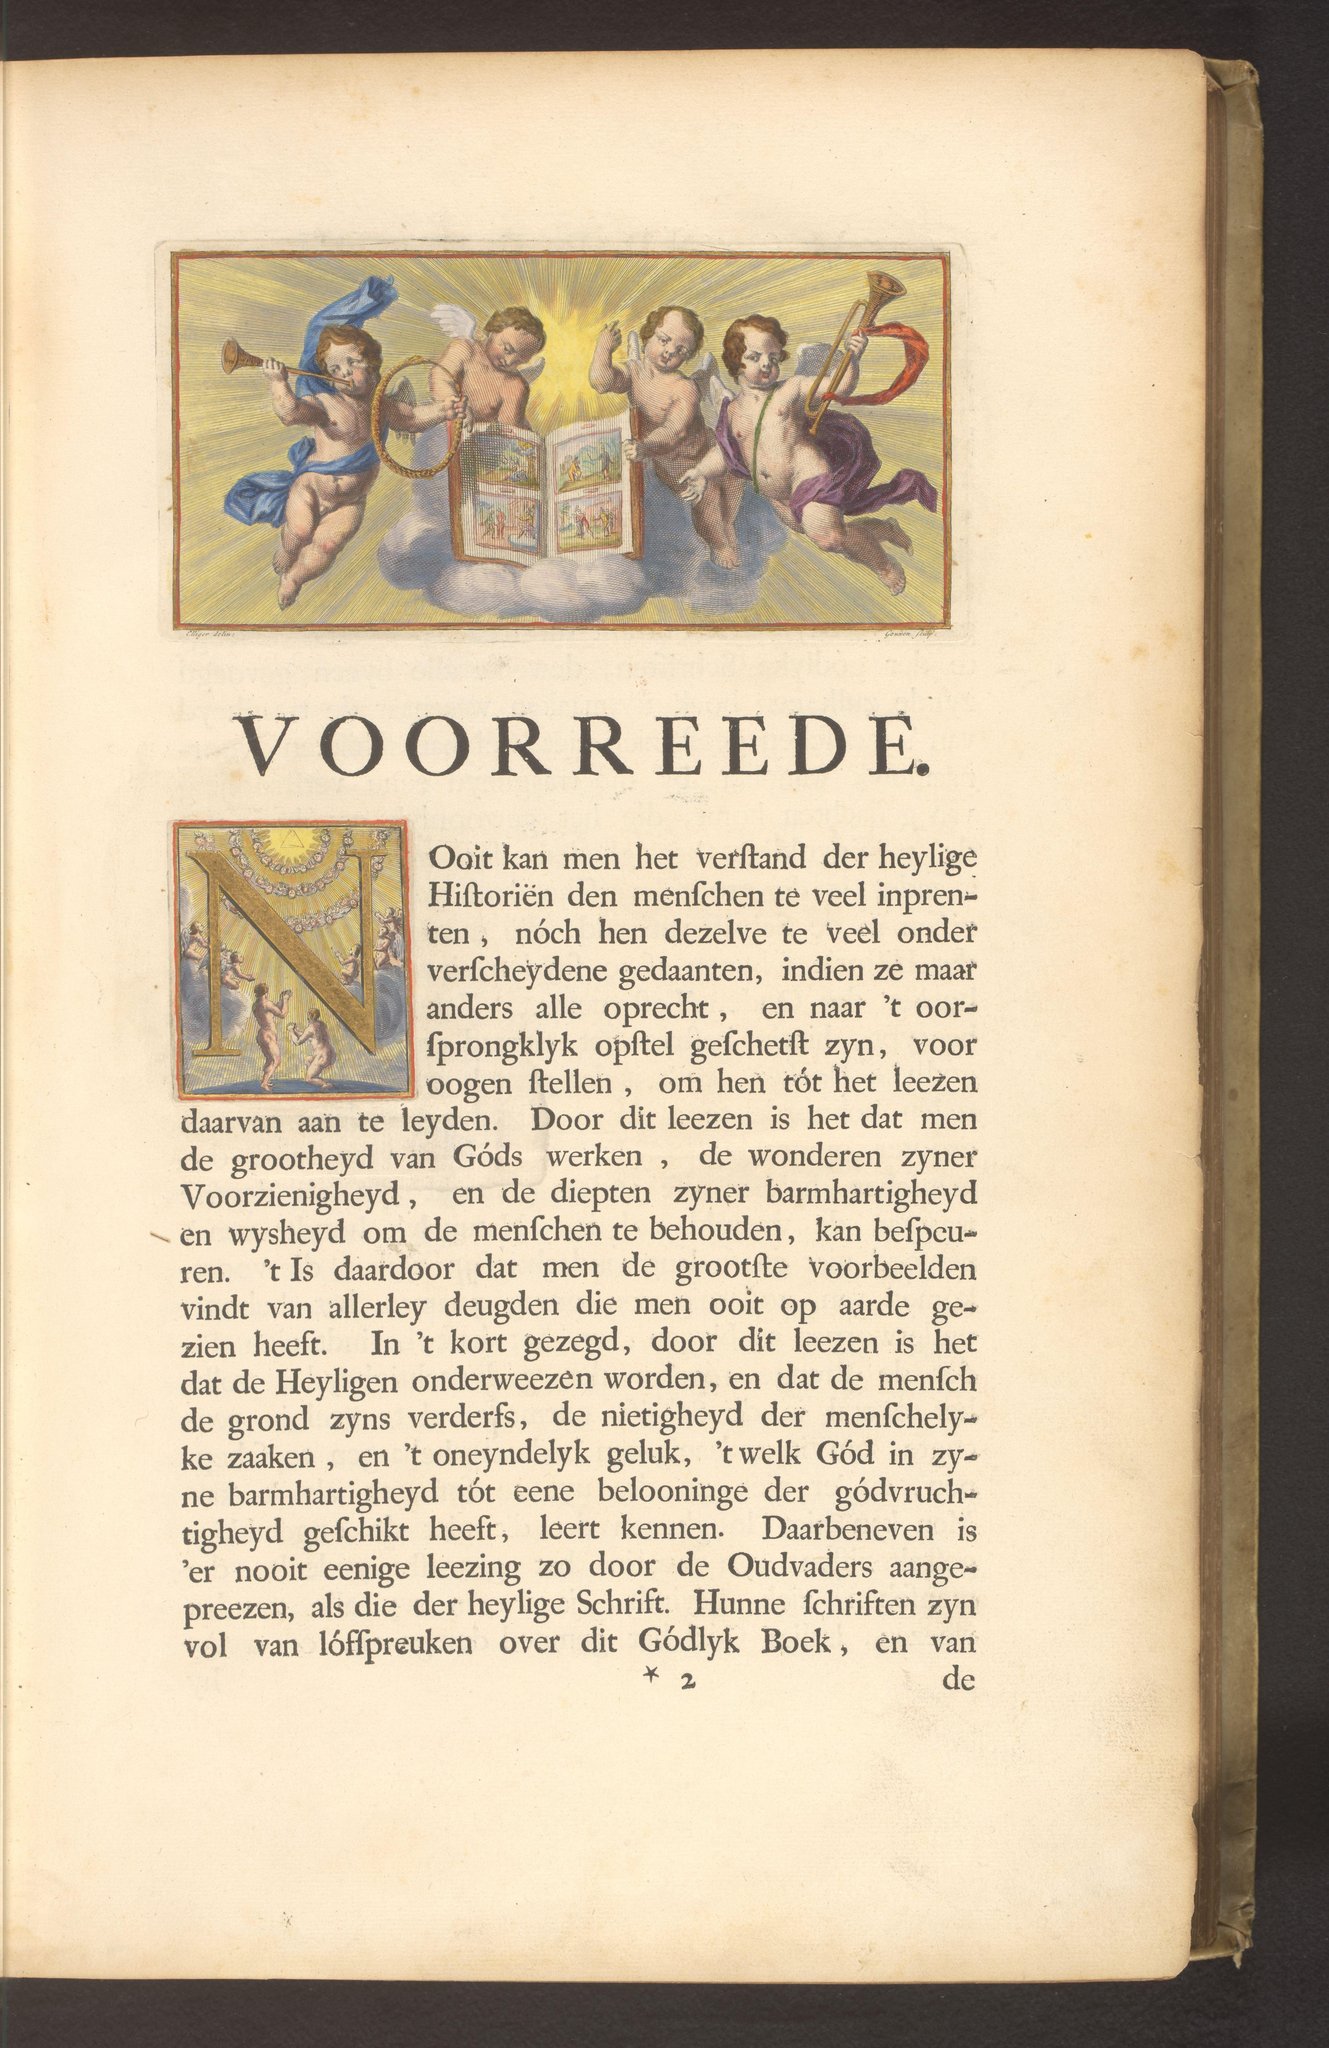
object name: text sheet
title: Eerste blad van de voorrede met engelen en initiaal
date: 1700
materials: paint, paper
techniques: brush, engraving, etching, hand coloring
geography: amsterdam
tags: resurrection of the dead ~ last judgement, book in which illustrations are essential - mm - book open, angel(s) represented as child(ren), historiated initial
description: Eerste blad van de voorrede met tekst en twee platen. Bovenaan een vignet met vier engelen die een opgeslagen exemplaar van een ingekleurde prentbijbel vasthouden. De tekst van de voorrede daaronder begint met een gehistorieerde initiaal N met een voorstelling van het Laatste Oordeel. Bij het eerste deel van de prentbijbel met het Oude Testament, uitgegeven door Pieter Mortier, Amsterdam 1700.